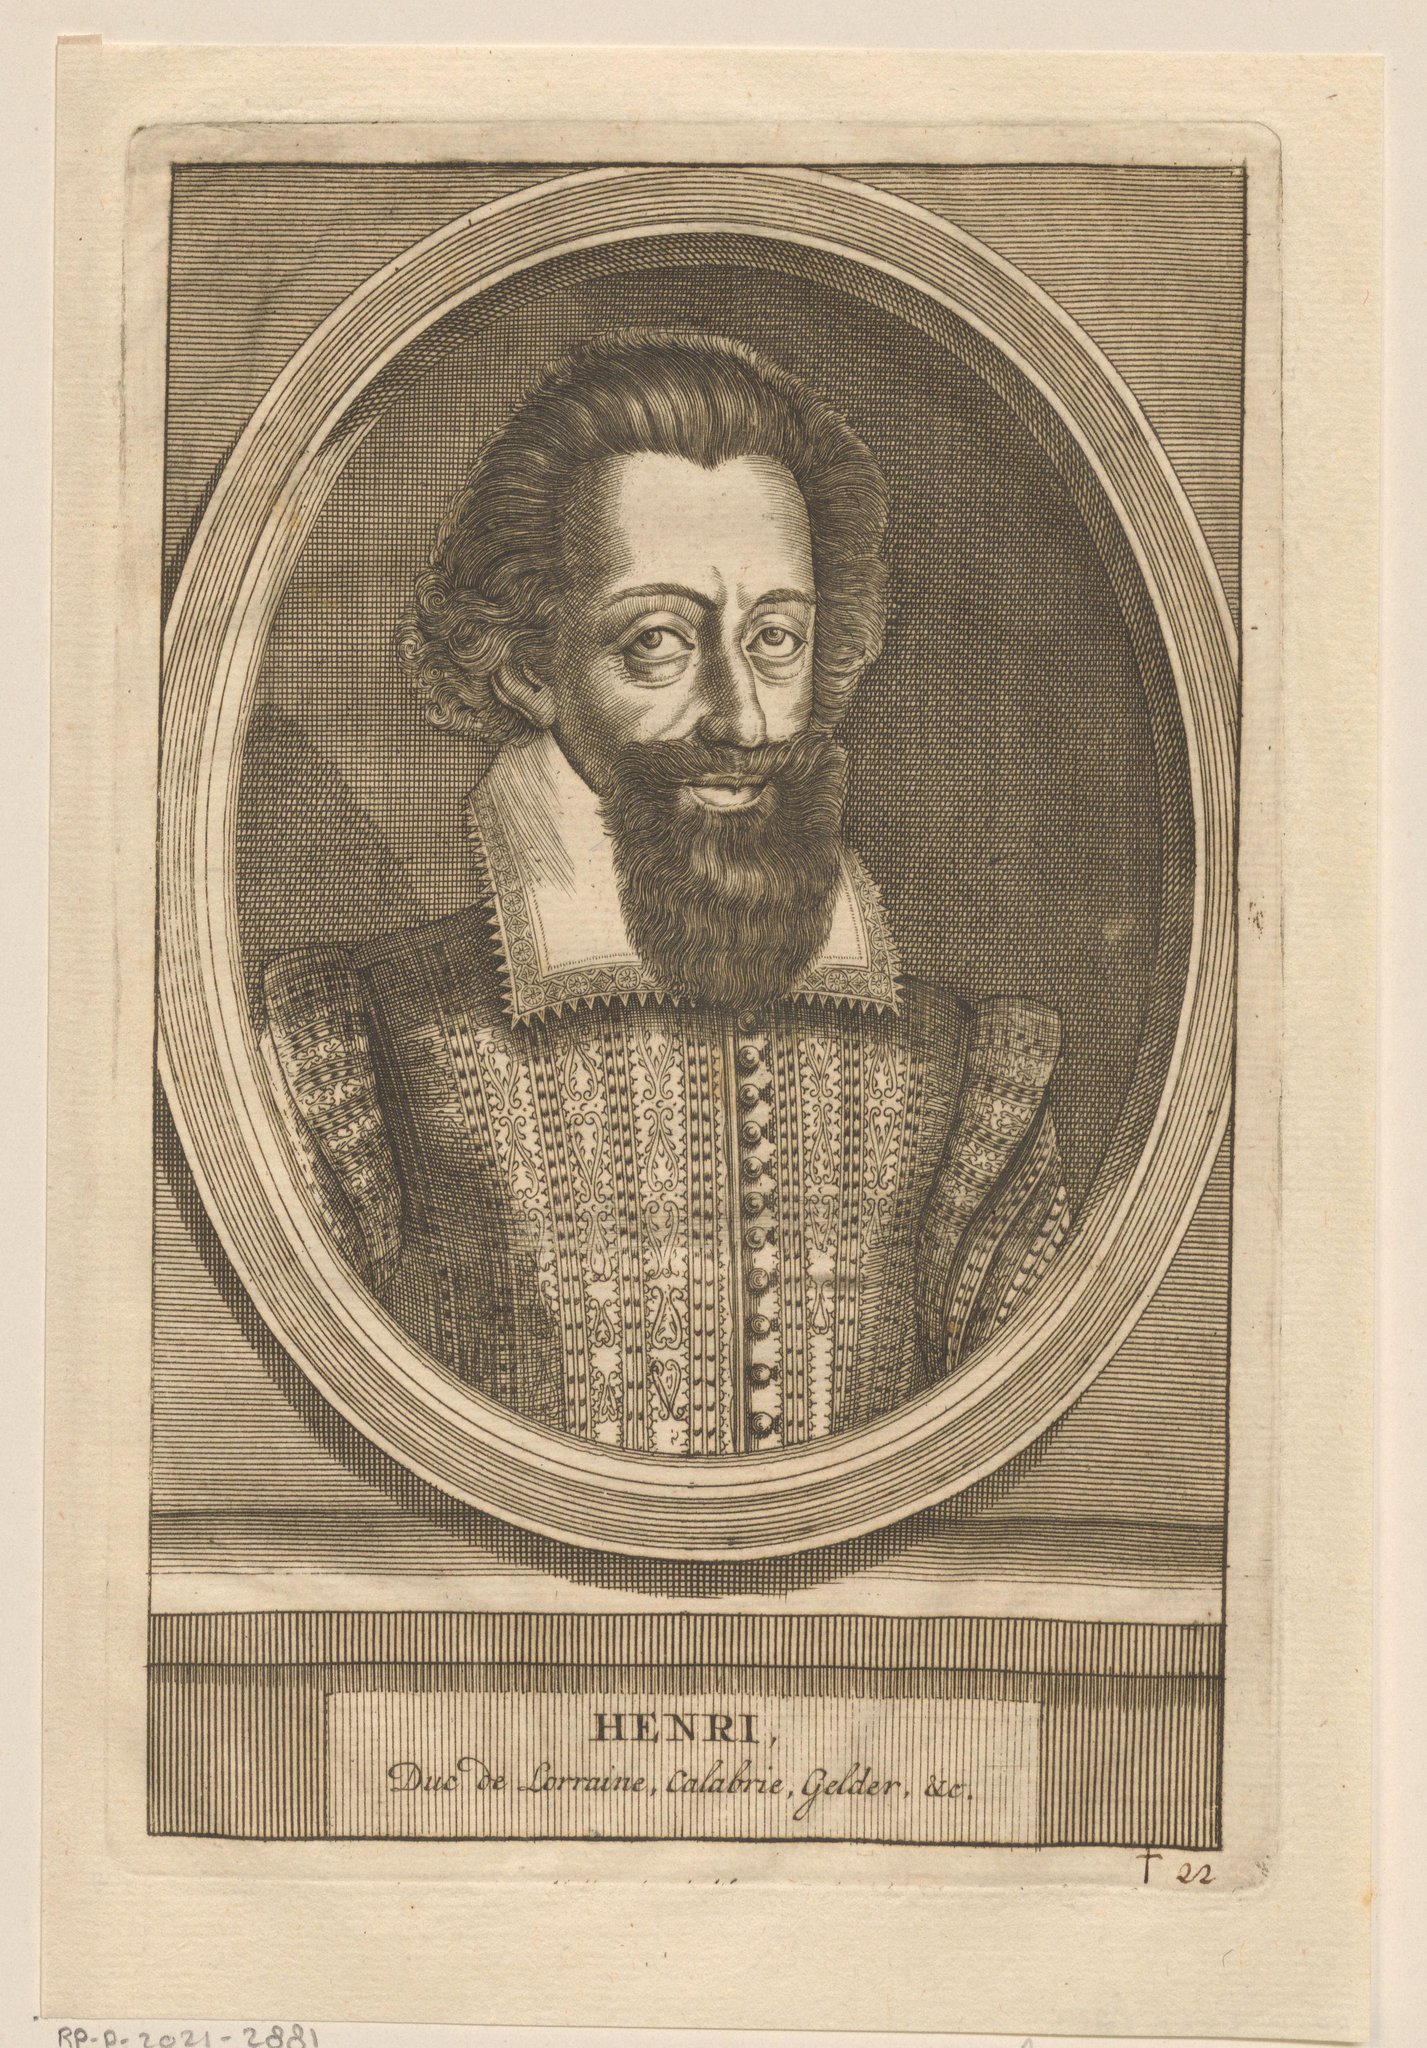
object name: print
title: Cabinet de XLI portraits des grands ducs, electeurs, archiducs, & autres princes & princesses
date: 1715-1730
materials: paper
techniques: engraving, etching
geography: leiden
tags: historical persons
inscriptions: inscription: ‘+22’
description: Vroegere staat van de prent gebruikt in: Clerck, Nicolaes de. Princelyck cabinet. Verthoonende 't leven afcomste ende afbeeldingen der voornaemste vorste[n] princen graven en[de] heeren van Europa (...). Delft: weduwe Nicolaes de Clerck, s.a. Prent met tekst op verso ook gebruikt in de 1625-editie.